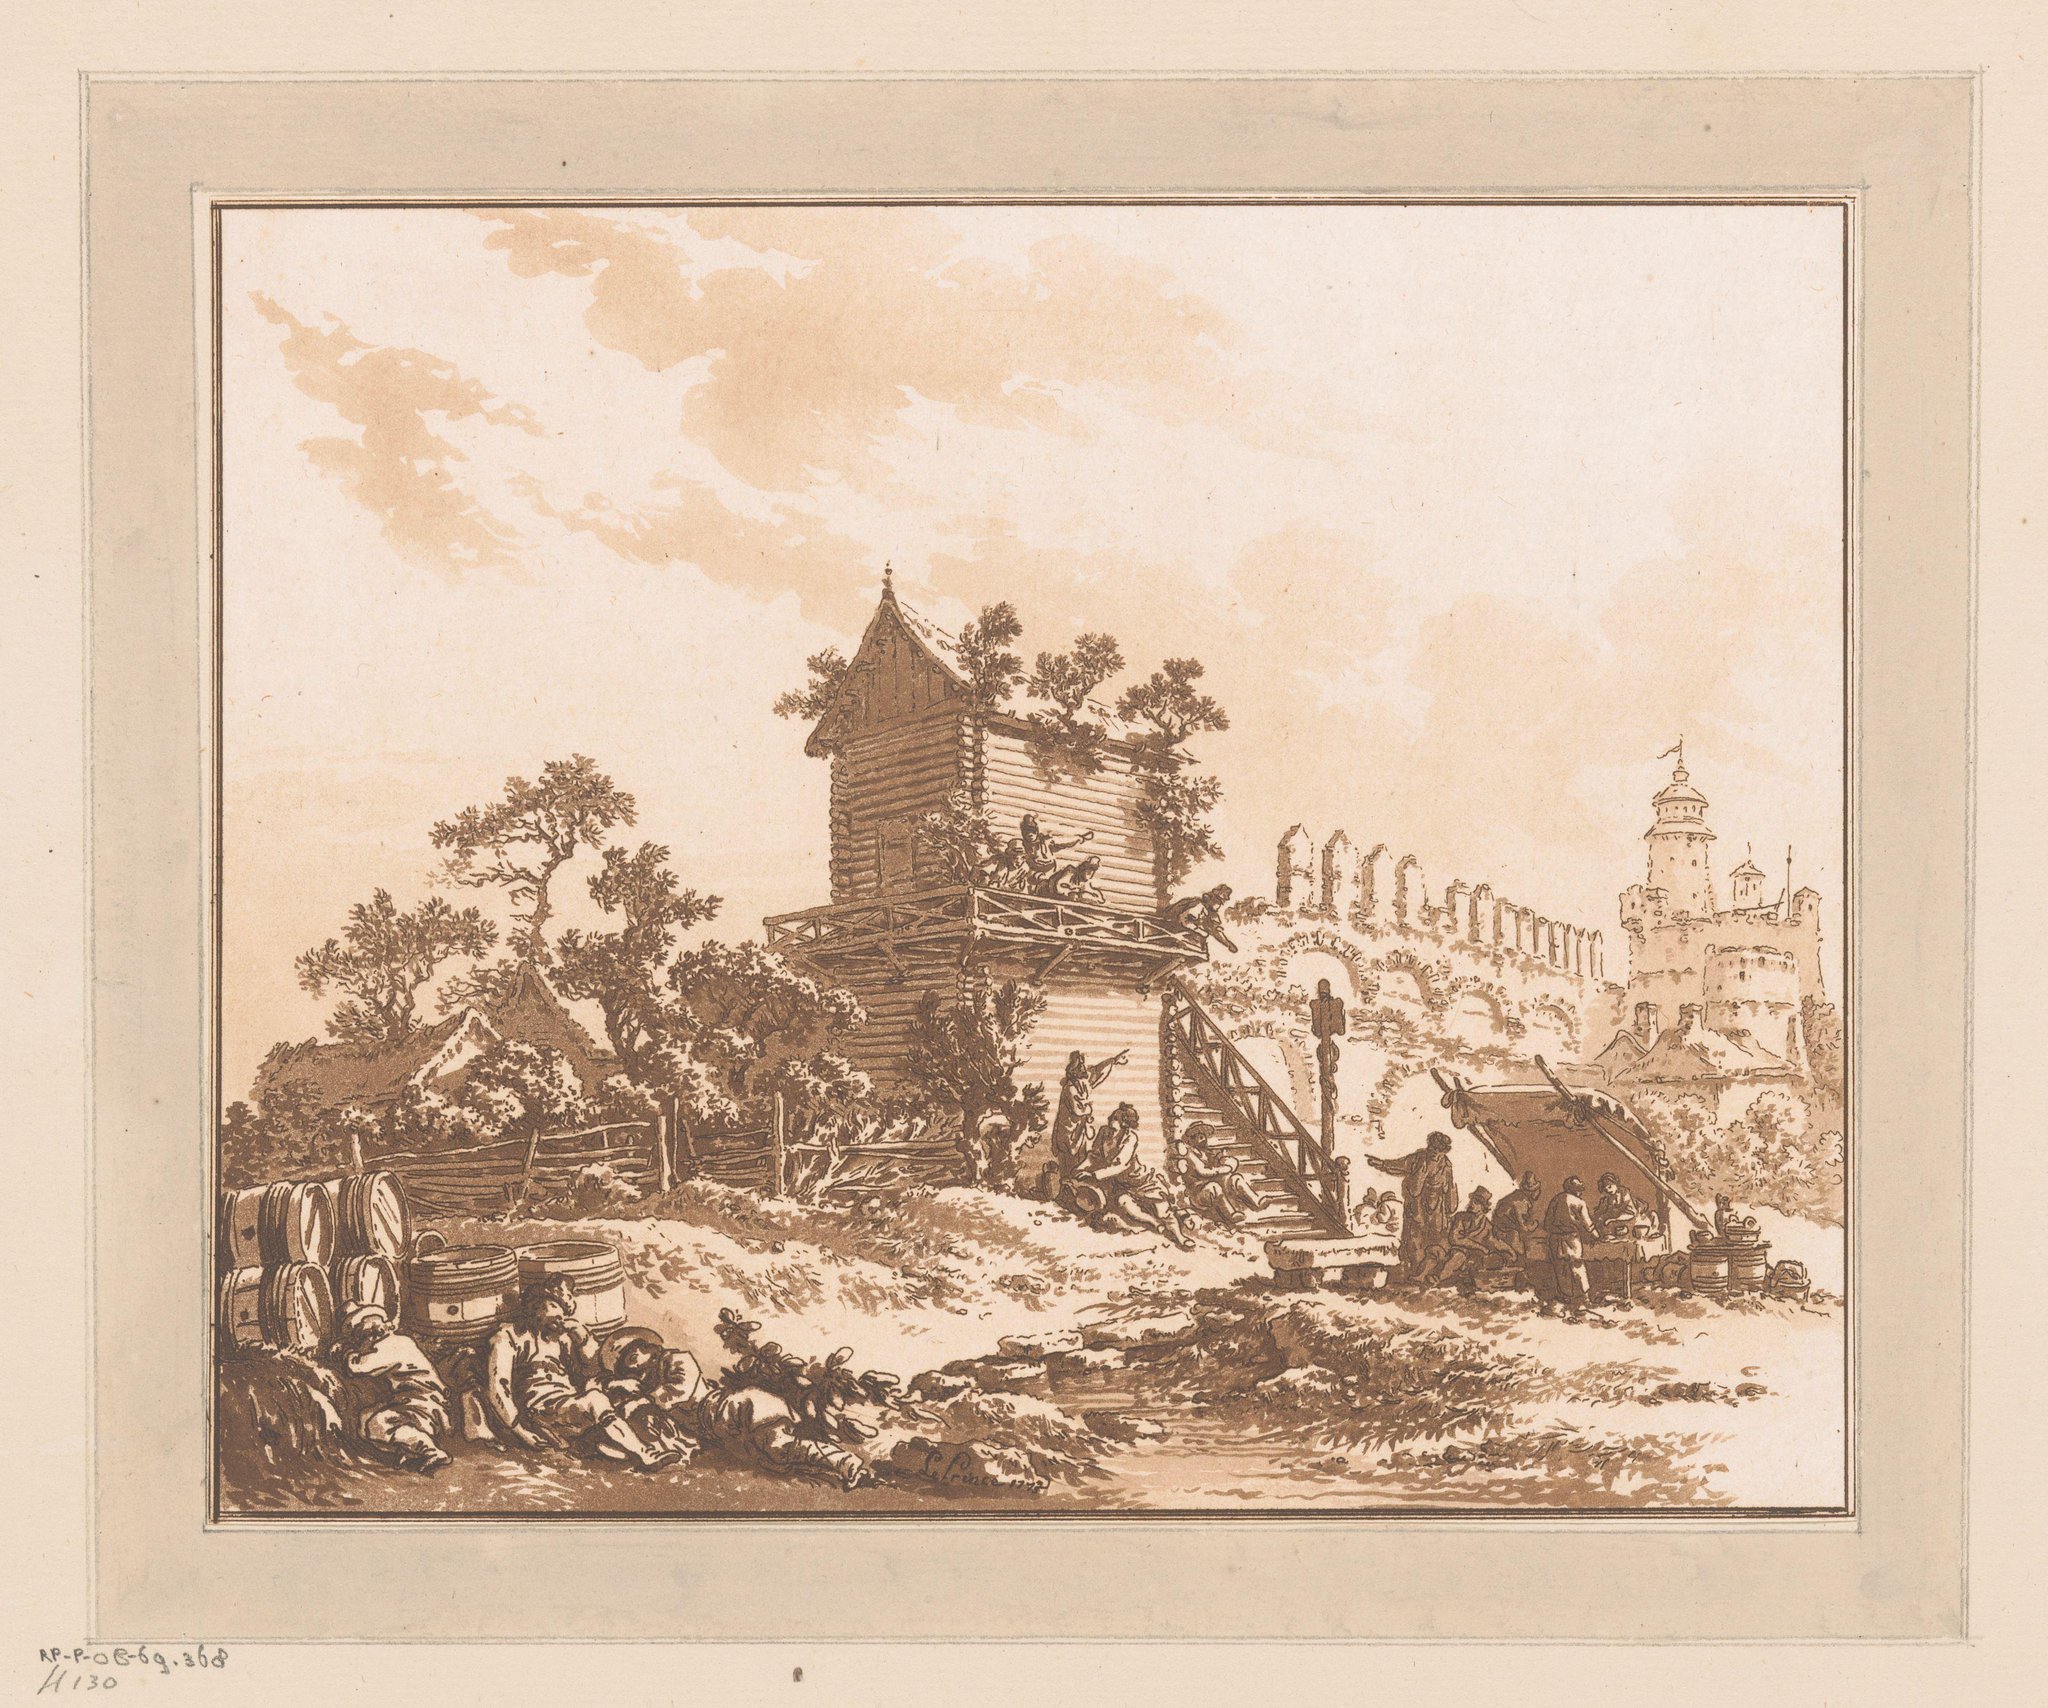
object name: print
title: Figuren en een kraam voor een huis bij een stadsmuur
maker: jean baptist leprince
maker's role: draughtsman, print maker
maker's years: 1734-1781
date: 1773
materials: paper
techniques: aquatint, etching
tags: stall, booth (~ market), city-walls, hut, cabin, lodge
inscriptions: date